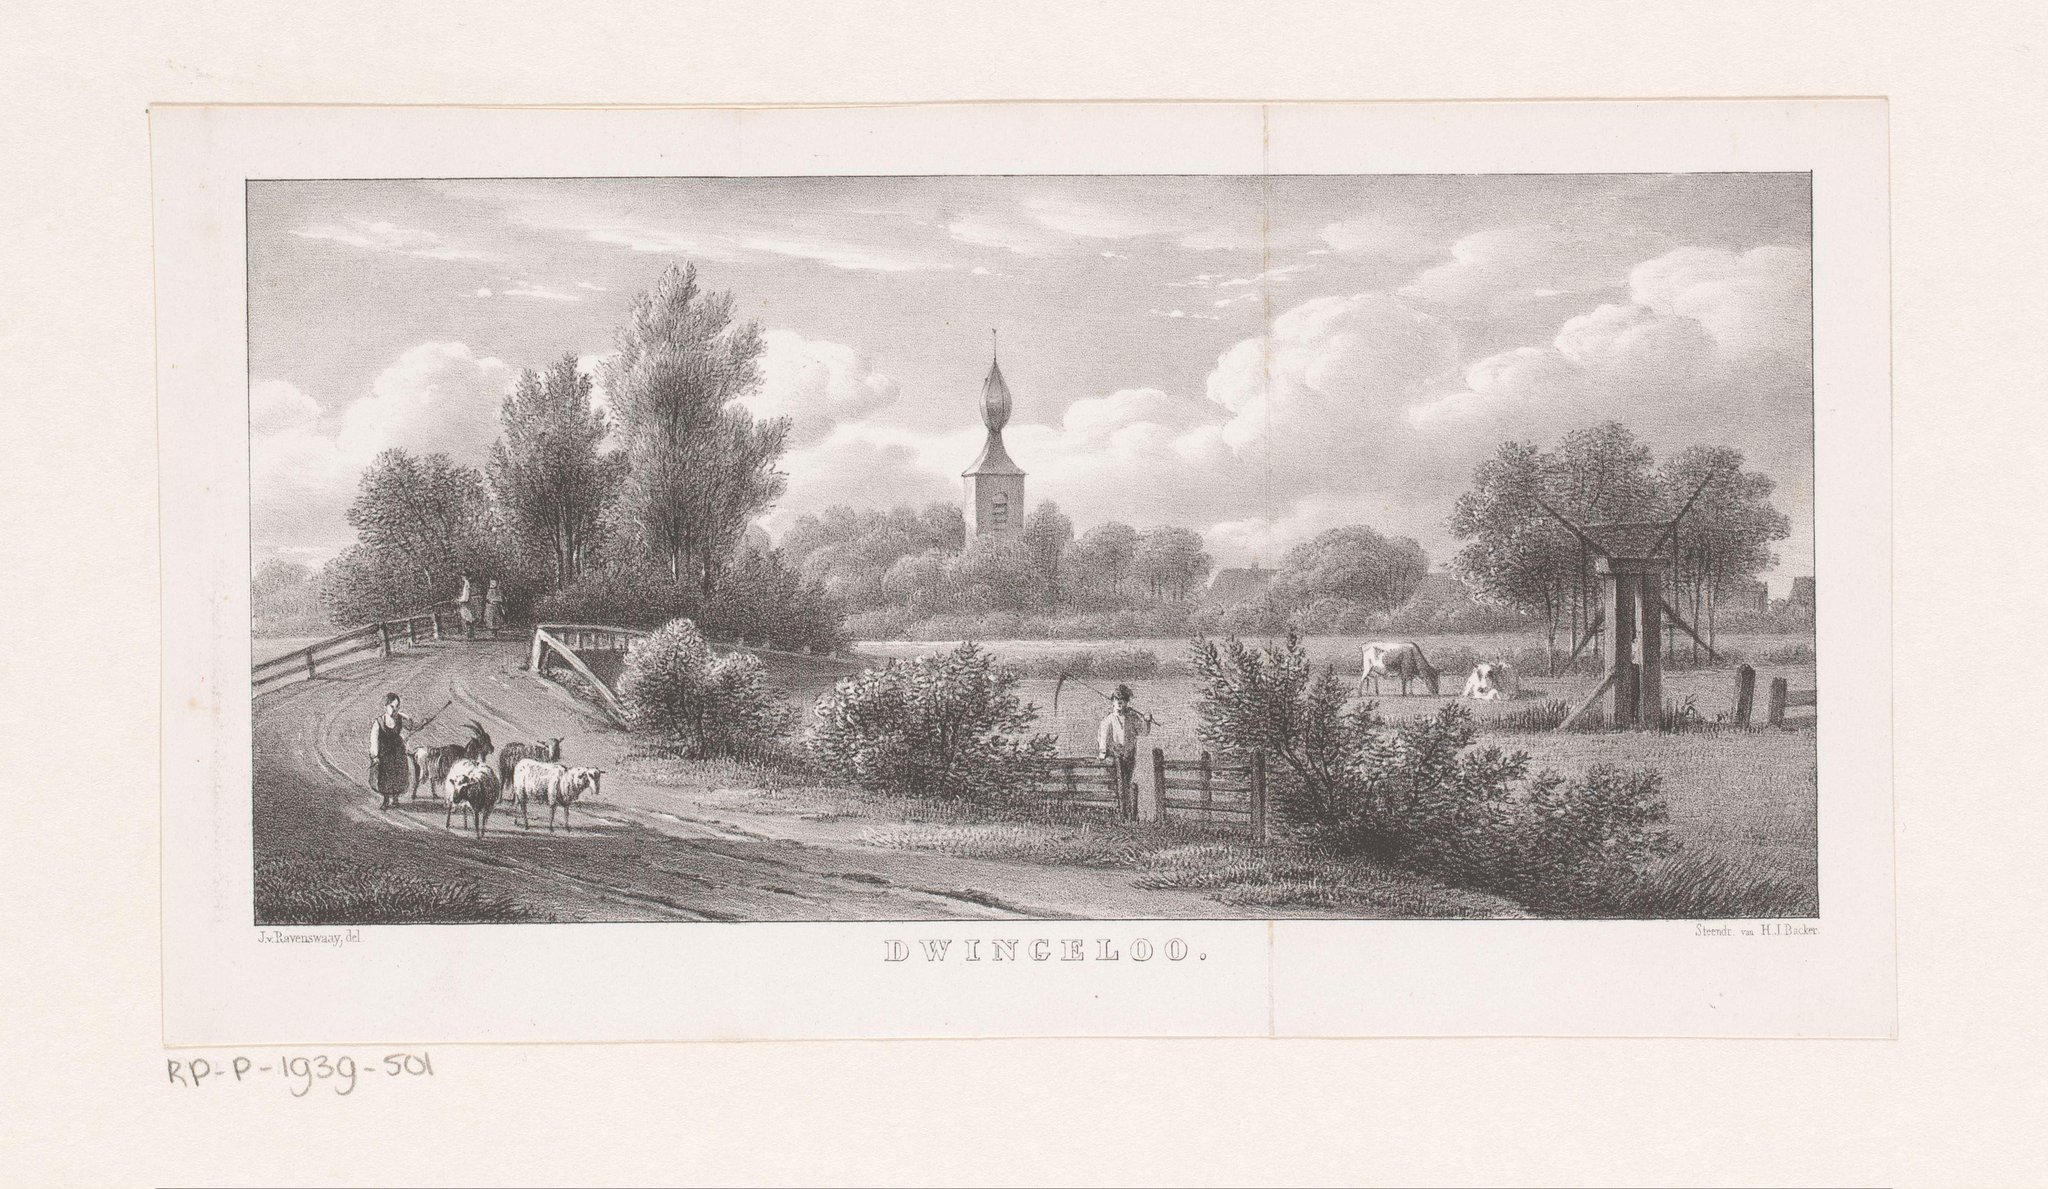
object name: print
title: Gezicht op Dwingeloo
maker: hilmar johannes backer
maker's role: print maker, printer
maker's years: 1804-1845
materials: paper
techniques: lithograph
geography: dordrecht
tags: city-view in general; 'veduta'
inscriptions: collector's mark: Lugt 2166, collector's mark: Lugt 2760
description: Gezicht op Dwingeloo met op de voorgrond een vrouw en vier schapen op een pad. Rechts een man met zeis in een veld met twee koeien. In de achtergrond een kerktoren.